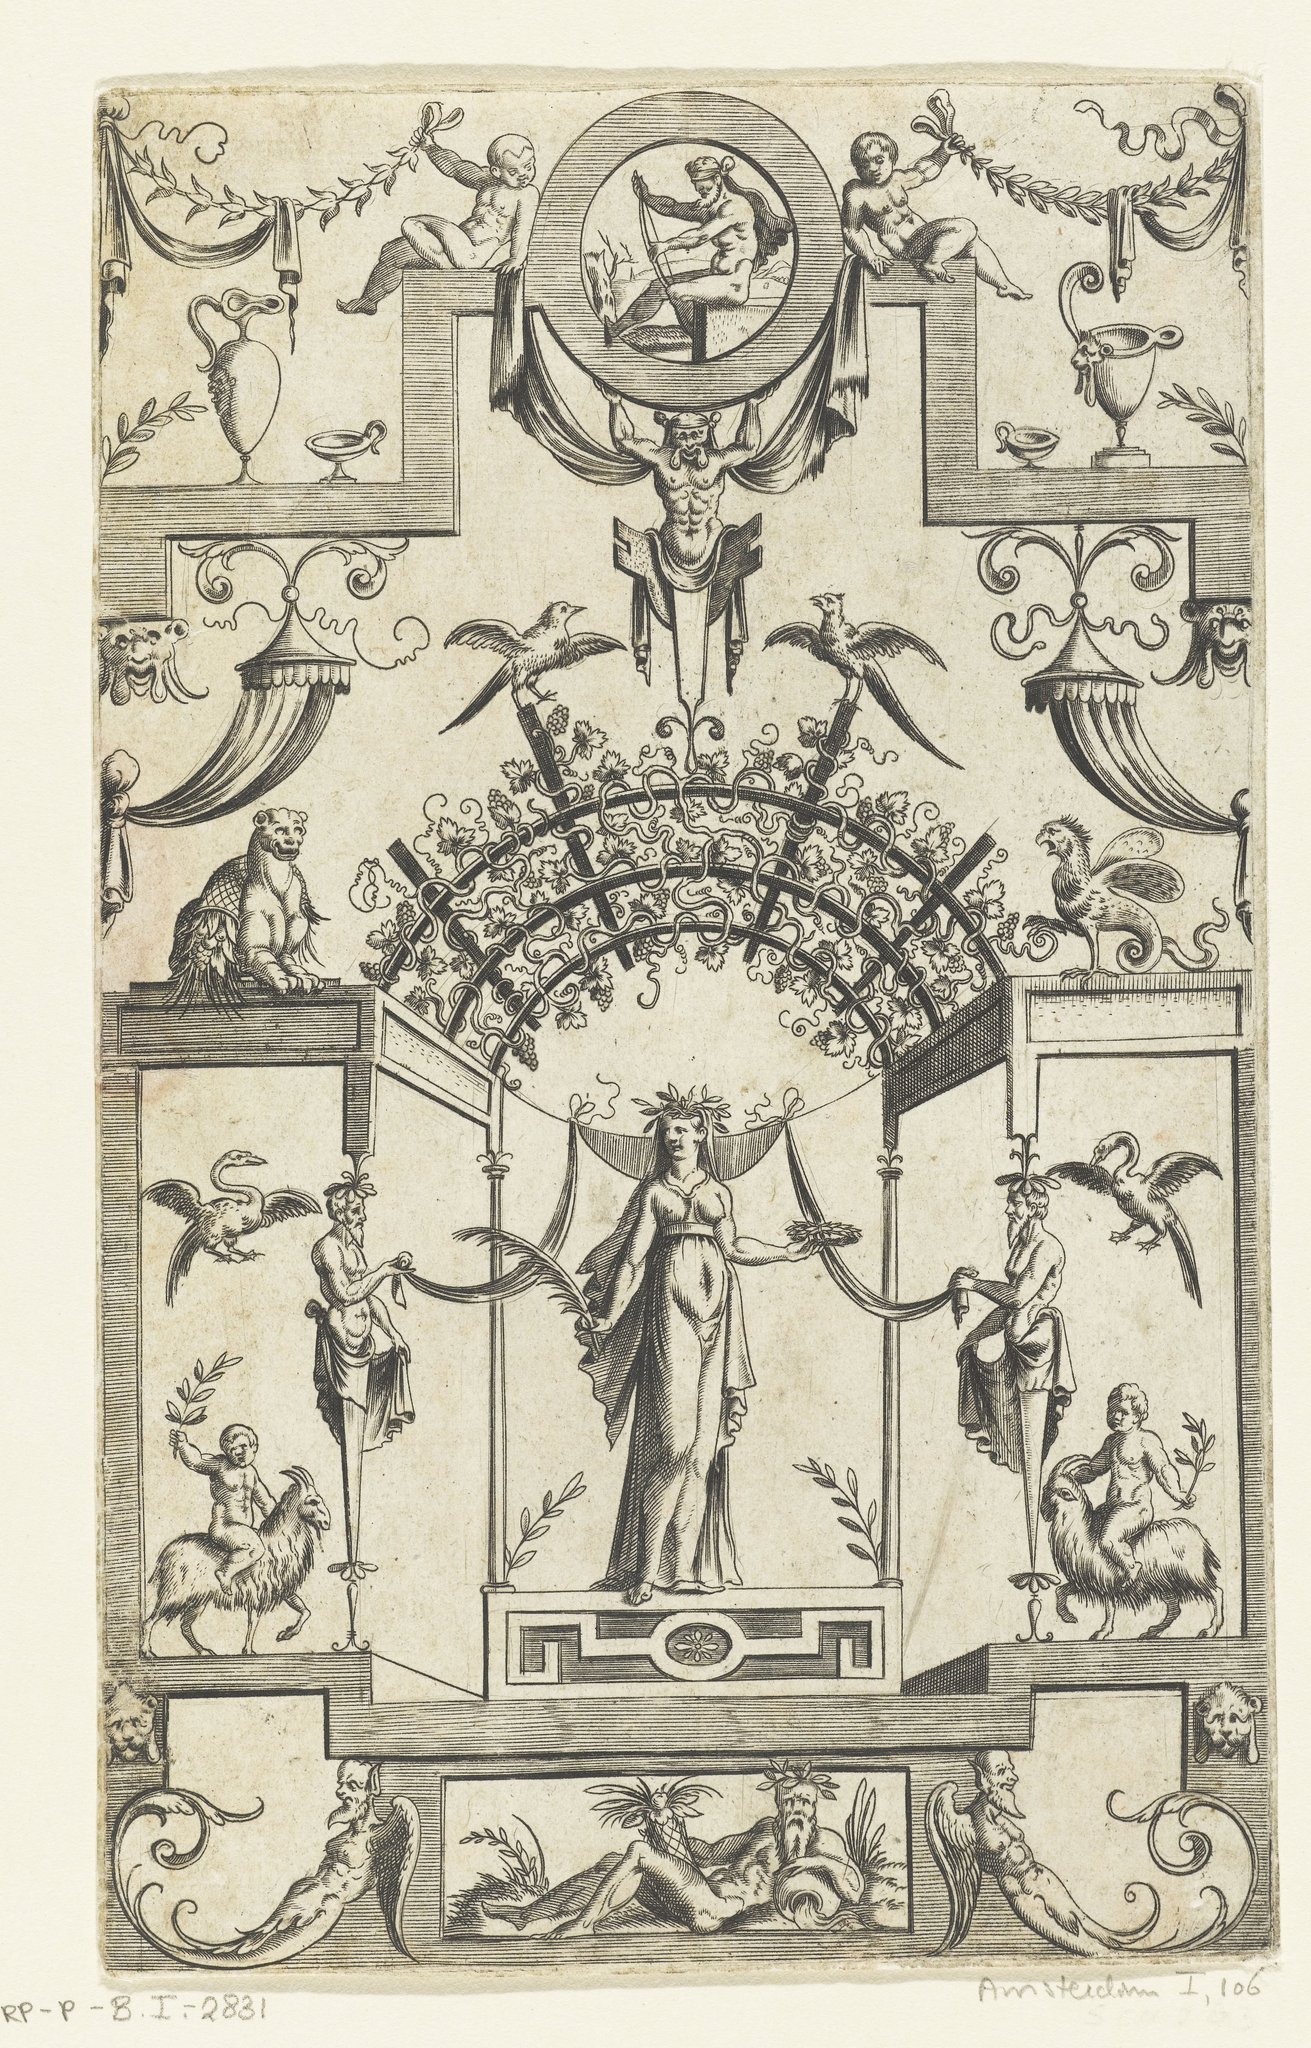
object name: ornament print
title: Vlakdecoratie met grotesken, in het midden staat Victoria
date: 1540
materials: paper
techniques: engraving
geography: netherlands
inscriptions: collector's mark: Lugt 240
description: Victoria staat onder een pergola. Middenonder ligt een riviergod.